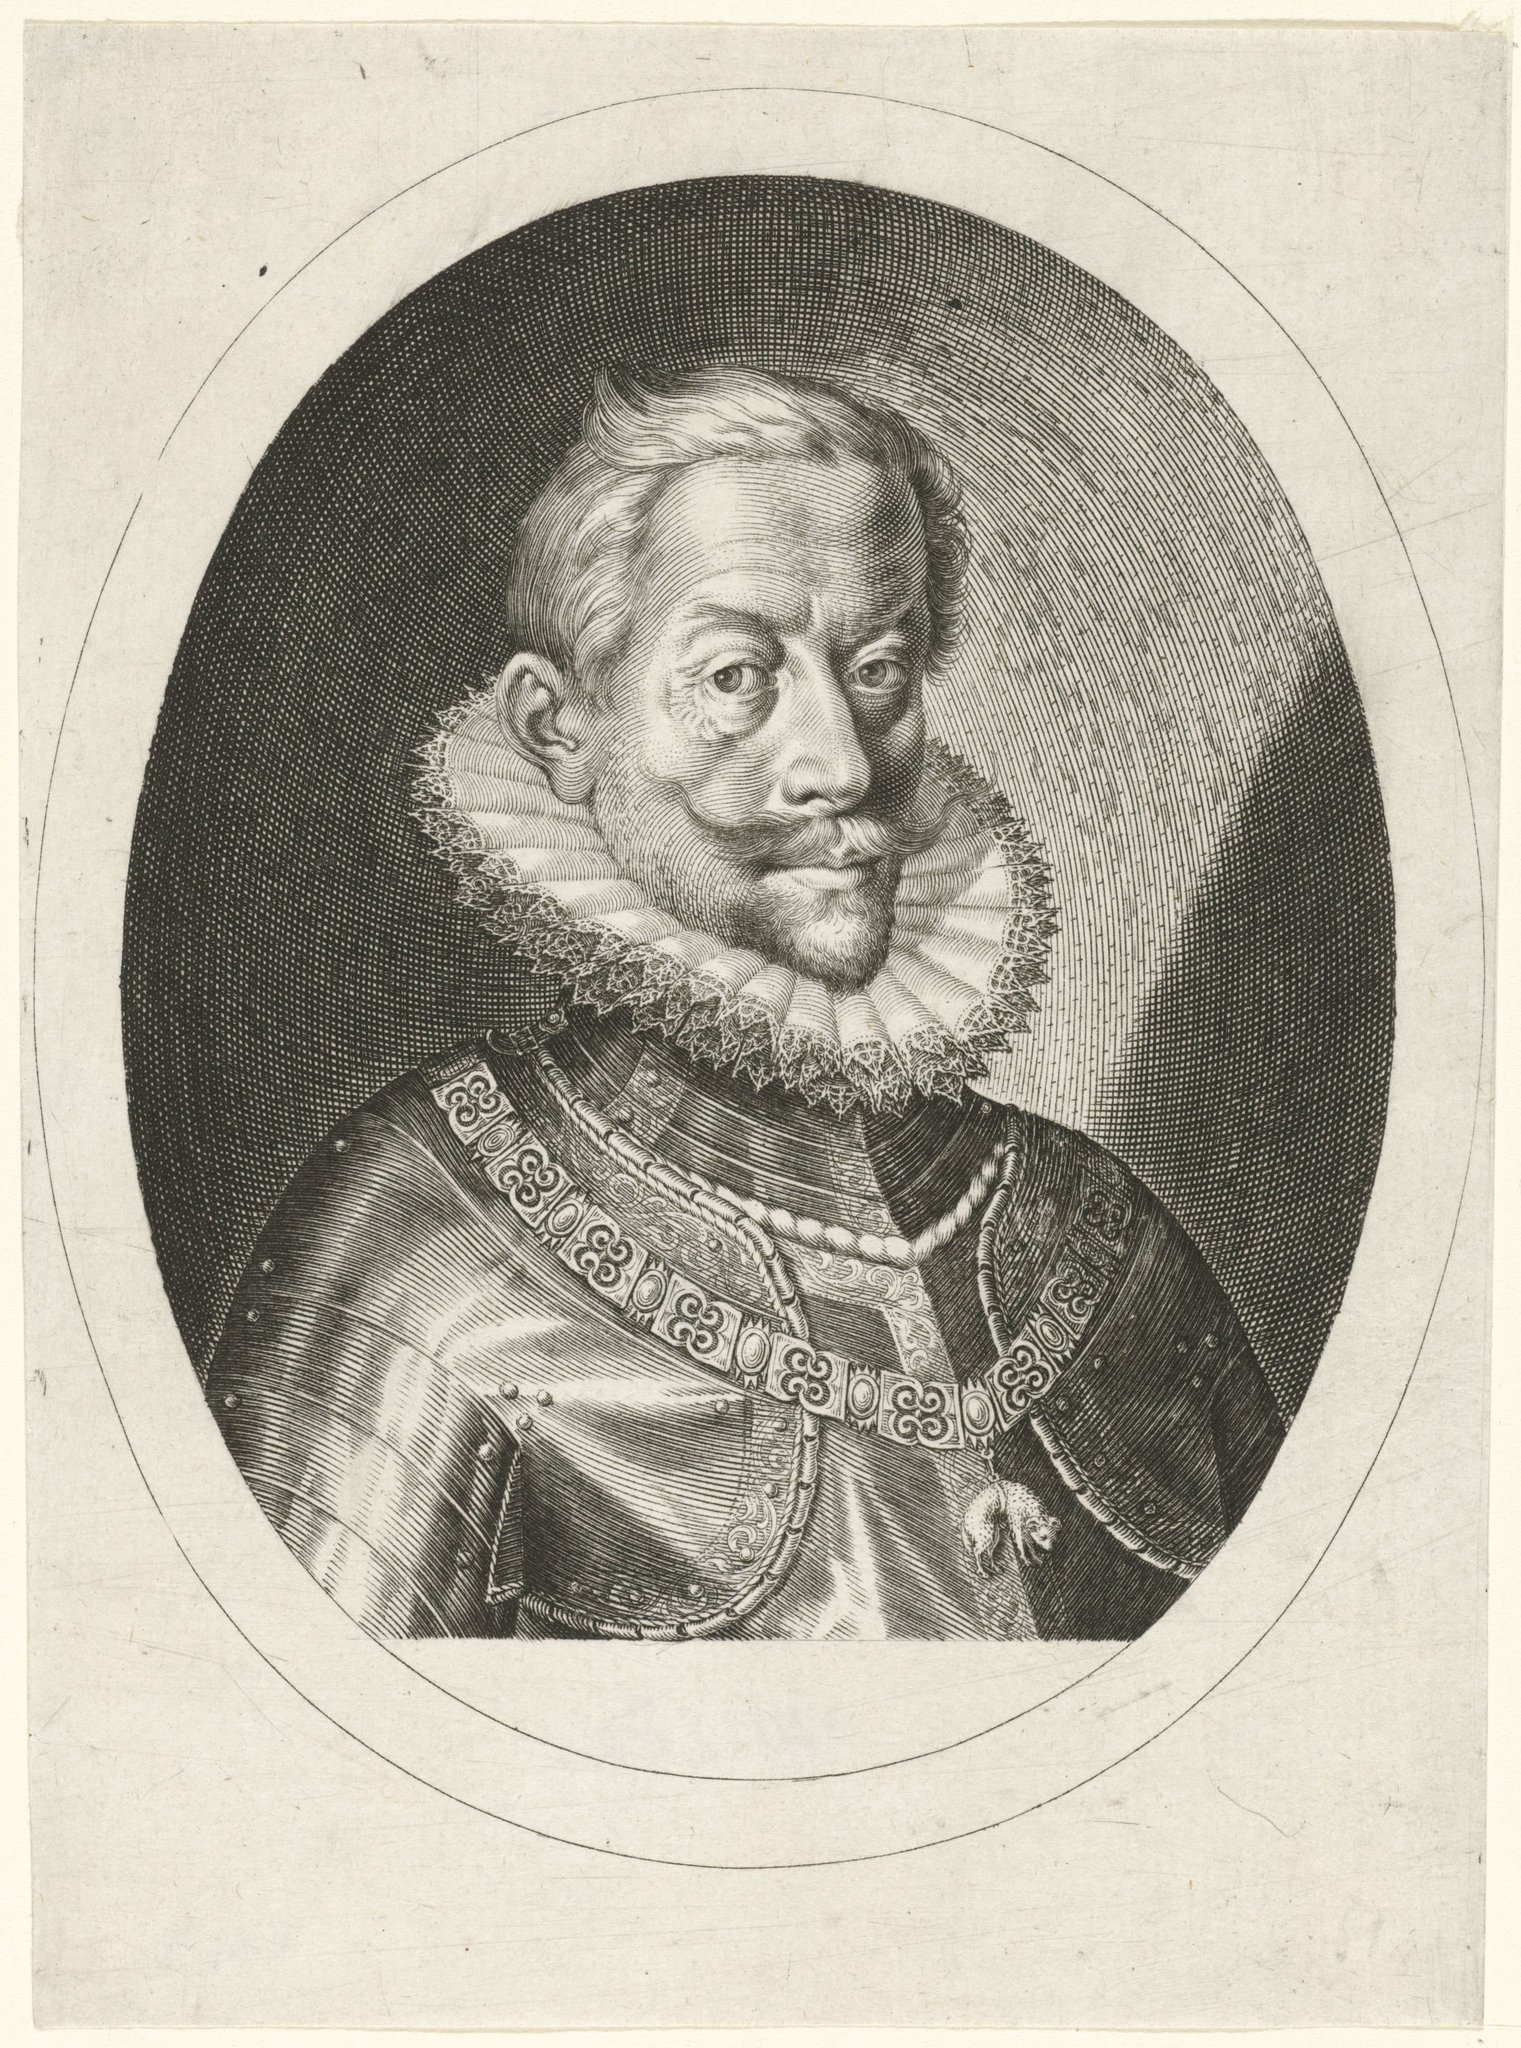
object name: print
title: Portret van keizer Mattias van Oostenrijk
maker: aegidius sadeler (ii)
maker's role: draughtsman, print maker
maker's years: 1568-1629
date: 1608-1629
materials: paper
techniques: engraving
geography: prague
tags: vienna, matthias van oostenrijk (rooms-duits keizer), knighthood order of the golden fleece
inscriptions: collector's mark: Lugt 2760, collector's mark: Lugt 2228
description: Portret van Keizer Mattias van Oostenrijk. Met ketting van de orde van het Gulden Vlies.